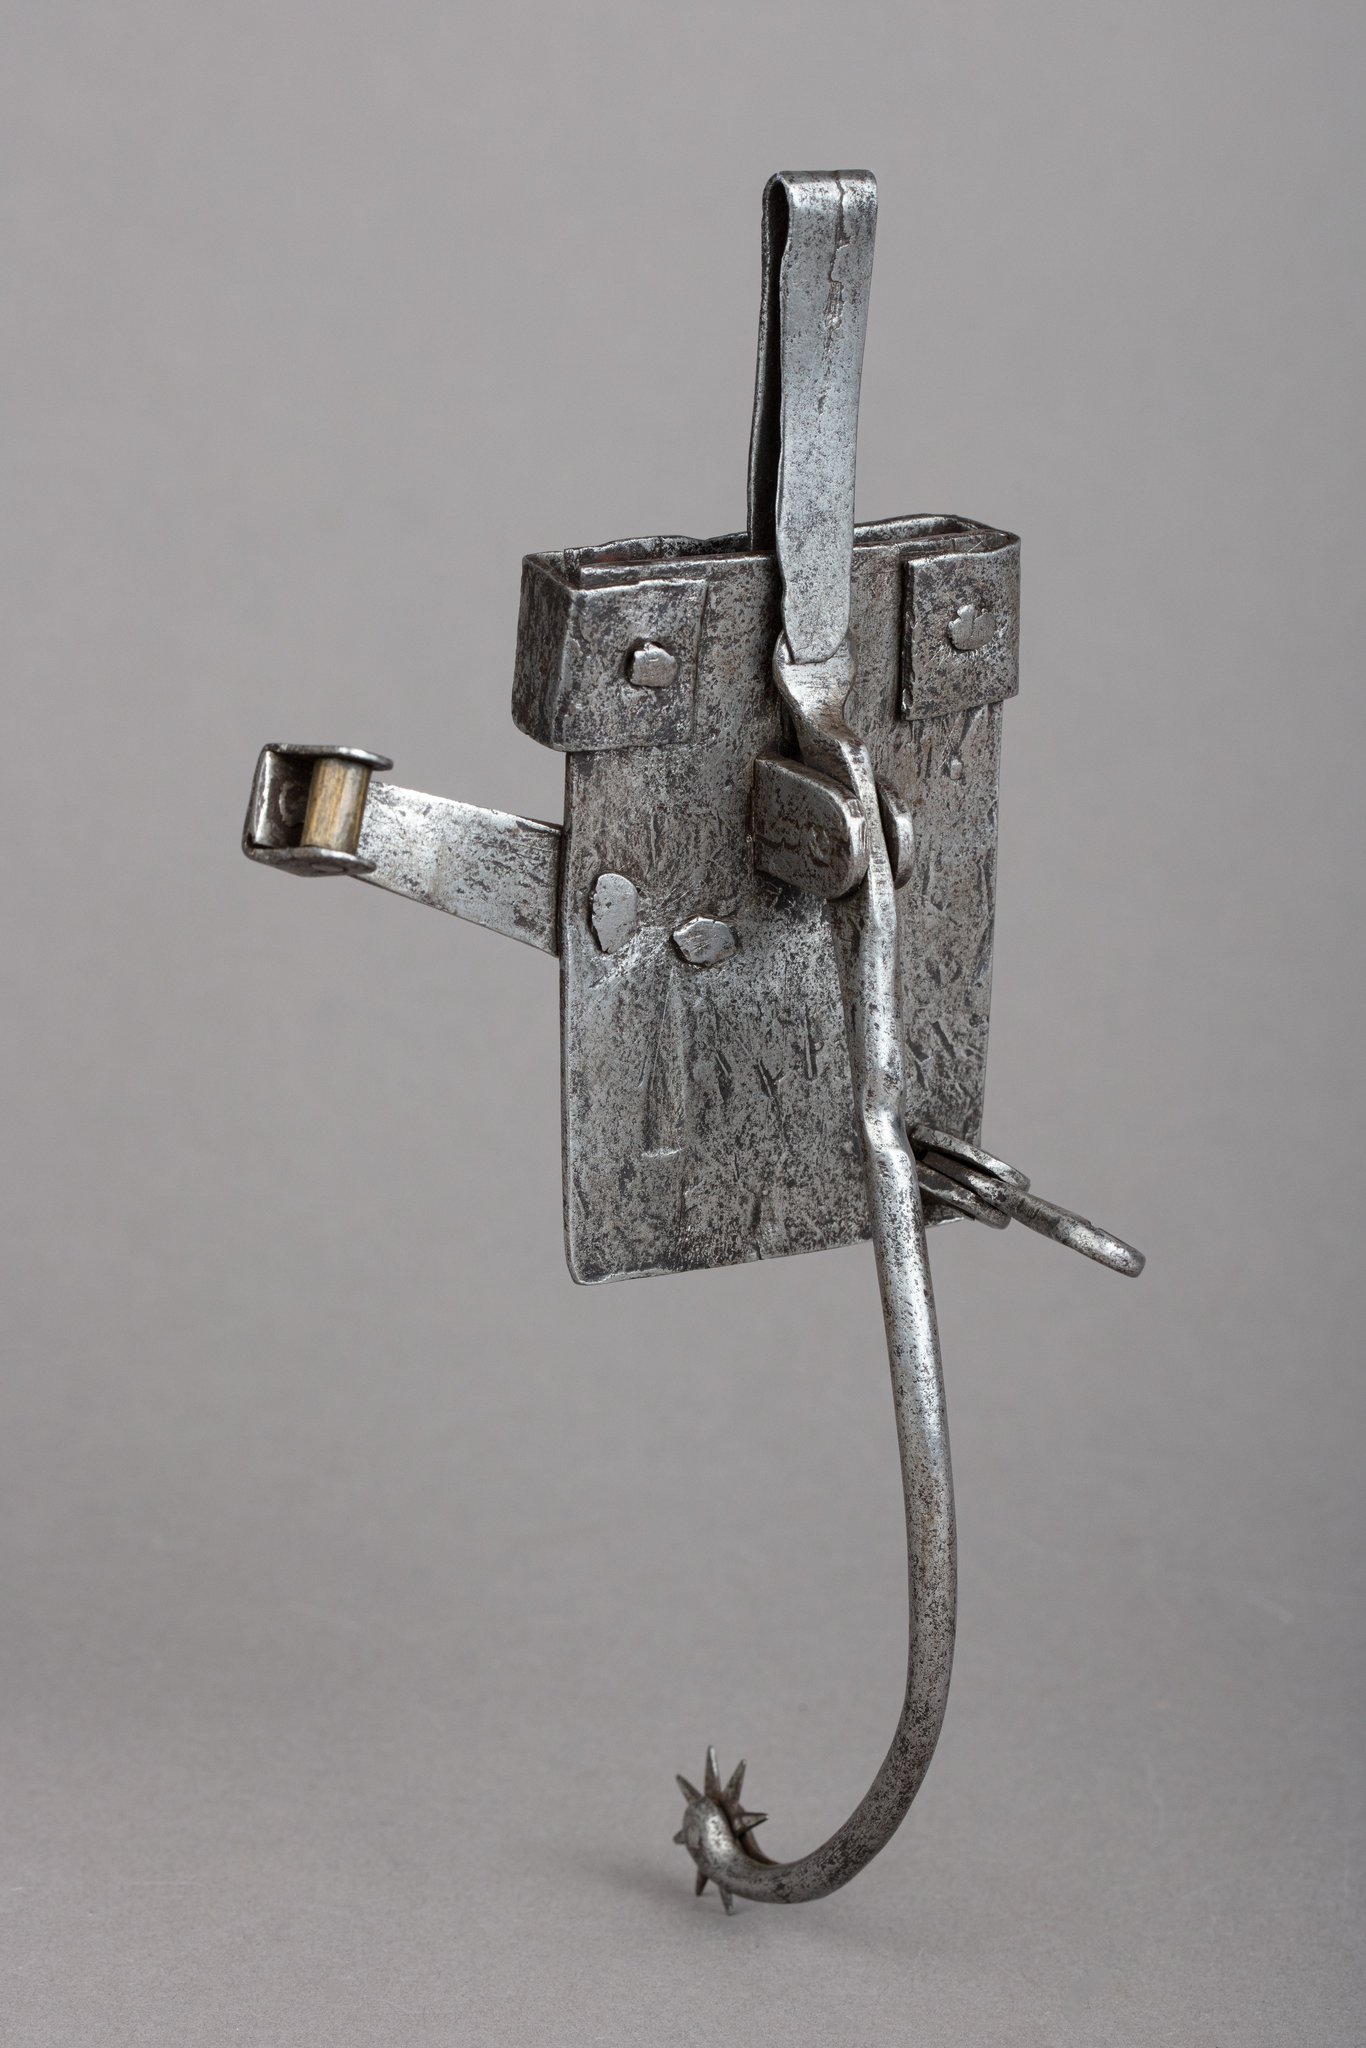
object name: spur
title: Mechanical Rowel Spur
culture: german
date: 1701-1800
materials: copper alloy, metal alloy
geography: germany